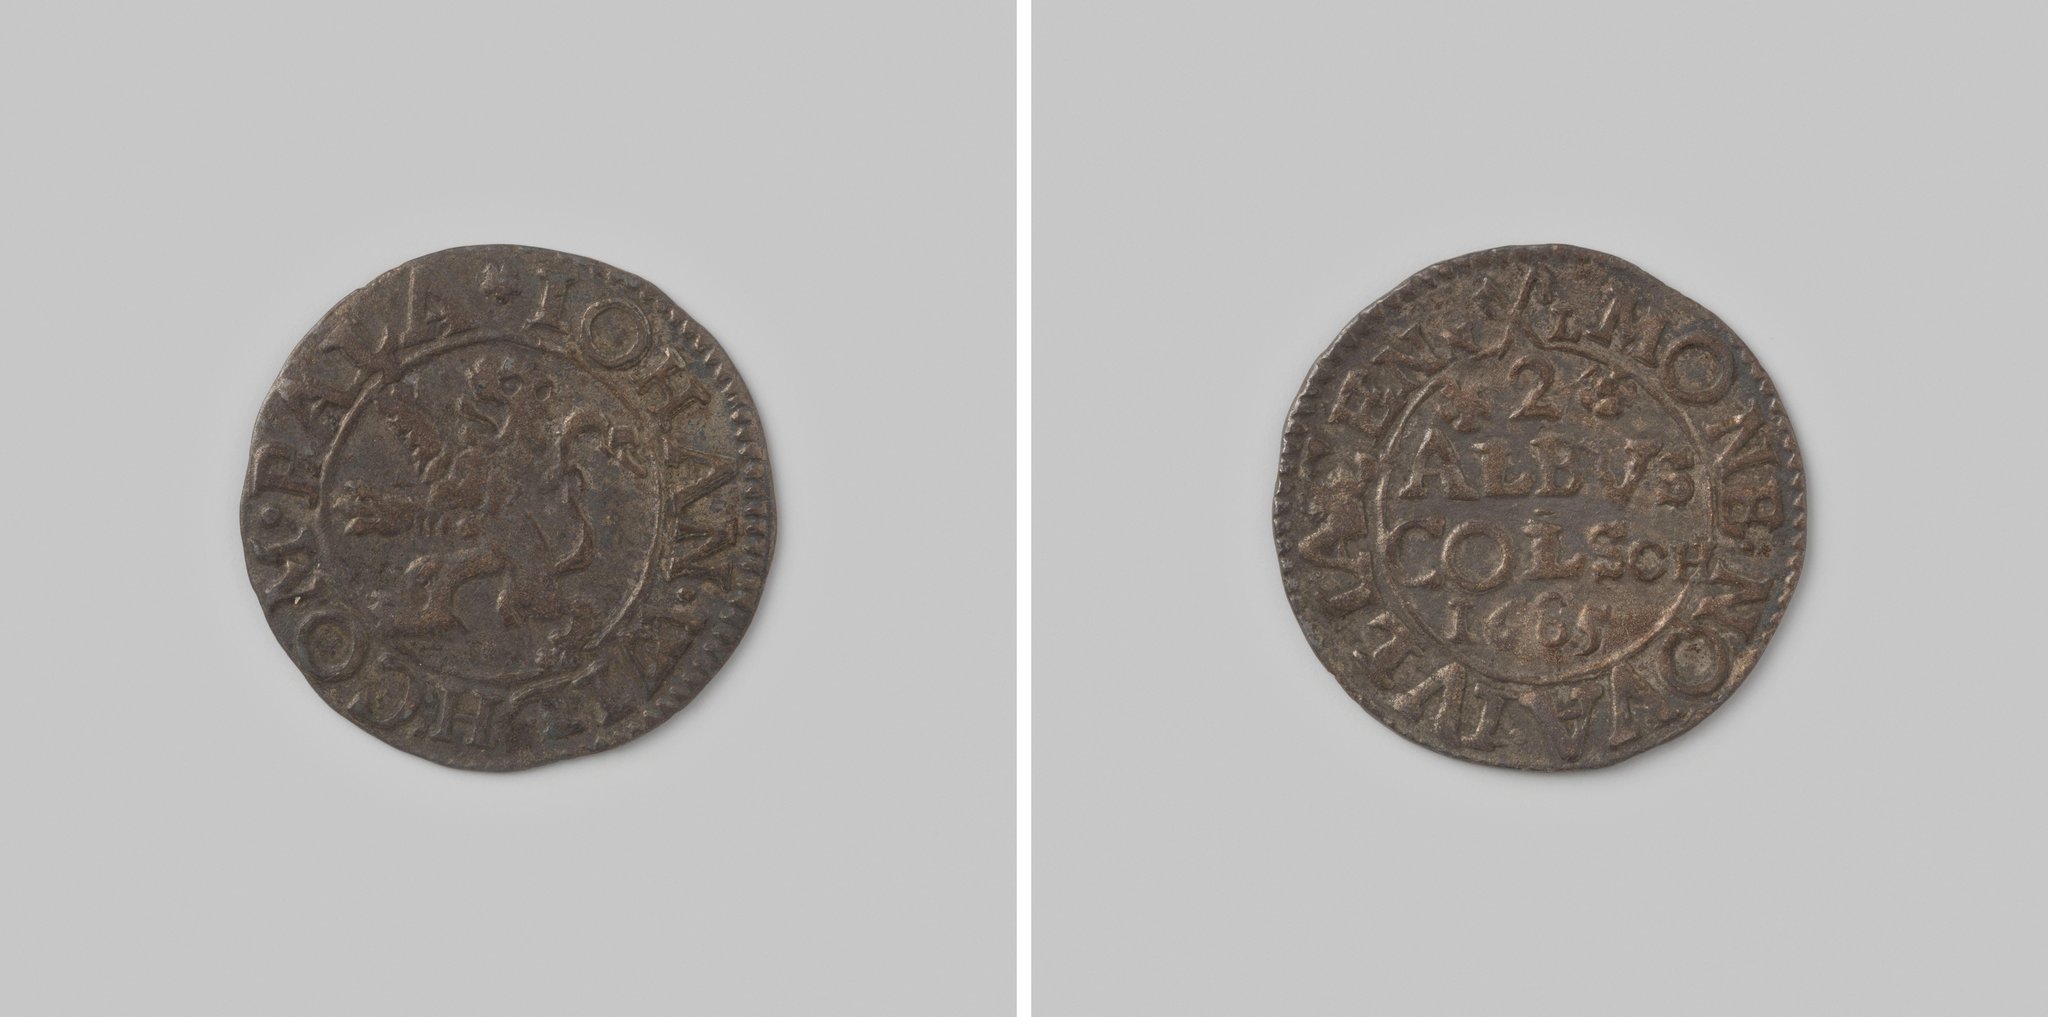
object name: coin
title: Julich-Berg, Johann Wilhelm, 2 albus cölsch, 1685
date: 1685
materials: silver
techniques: striking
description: Zilveren munt. Voorzijde: klimmende leeuw naar links. Keerzijde: waarde-aanduiding in drie regels, waaronder jaartal.